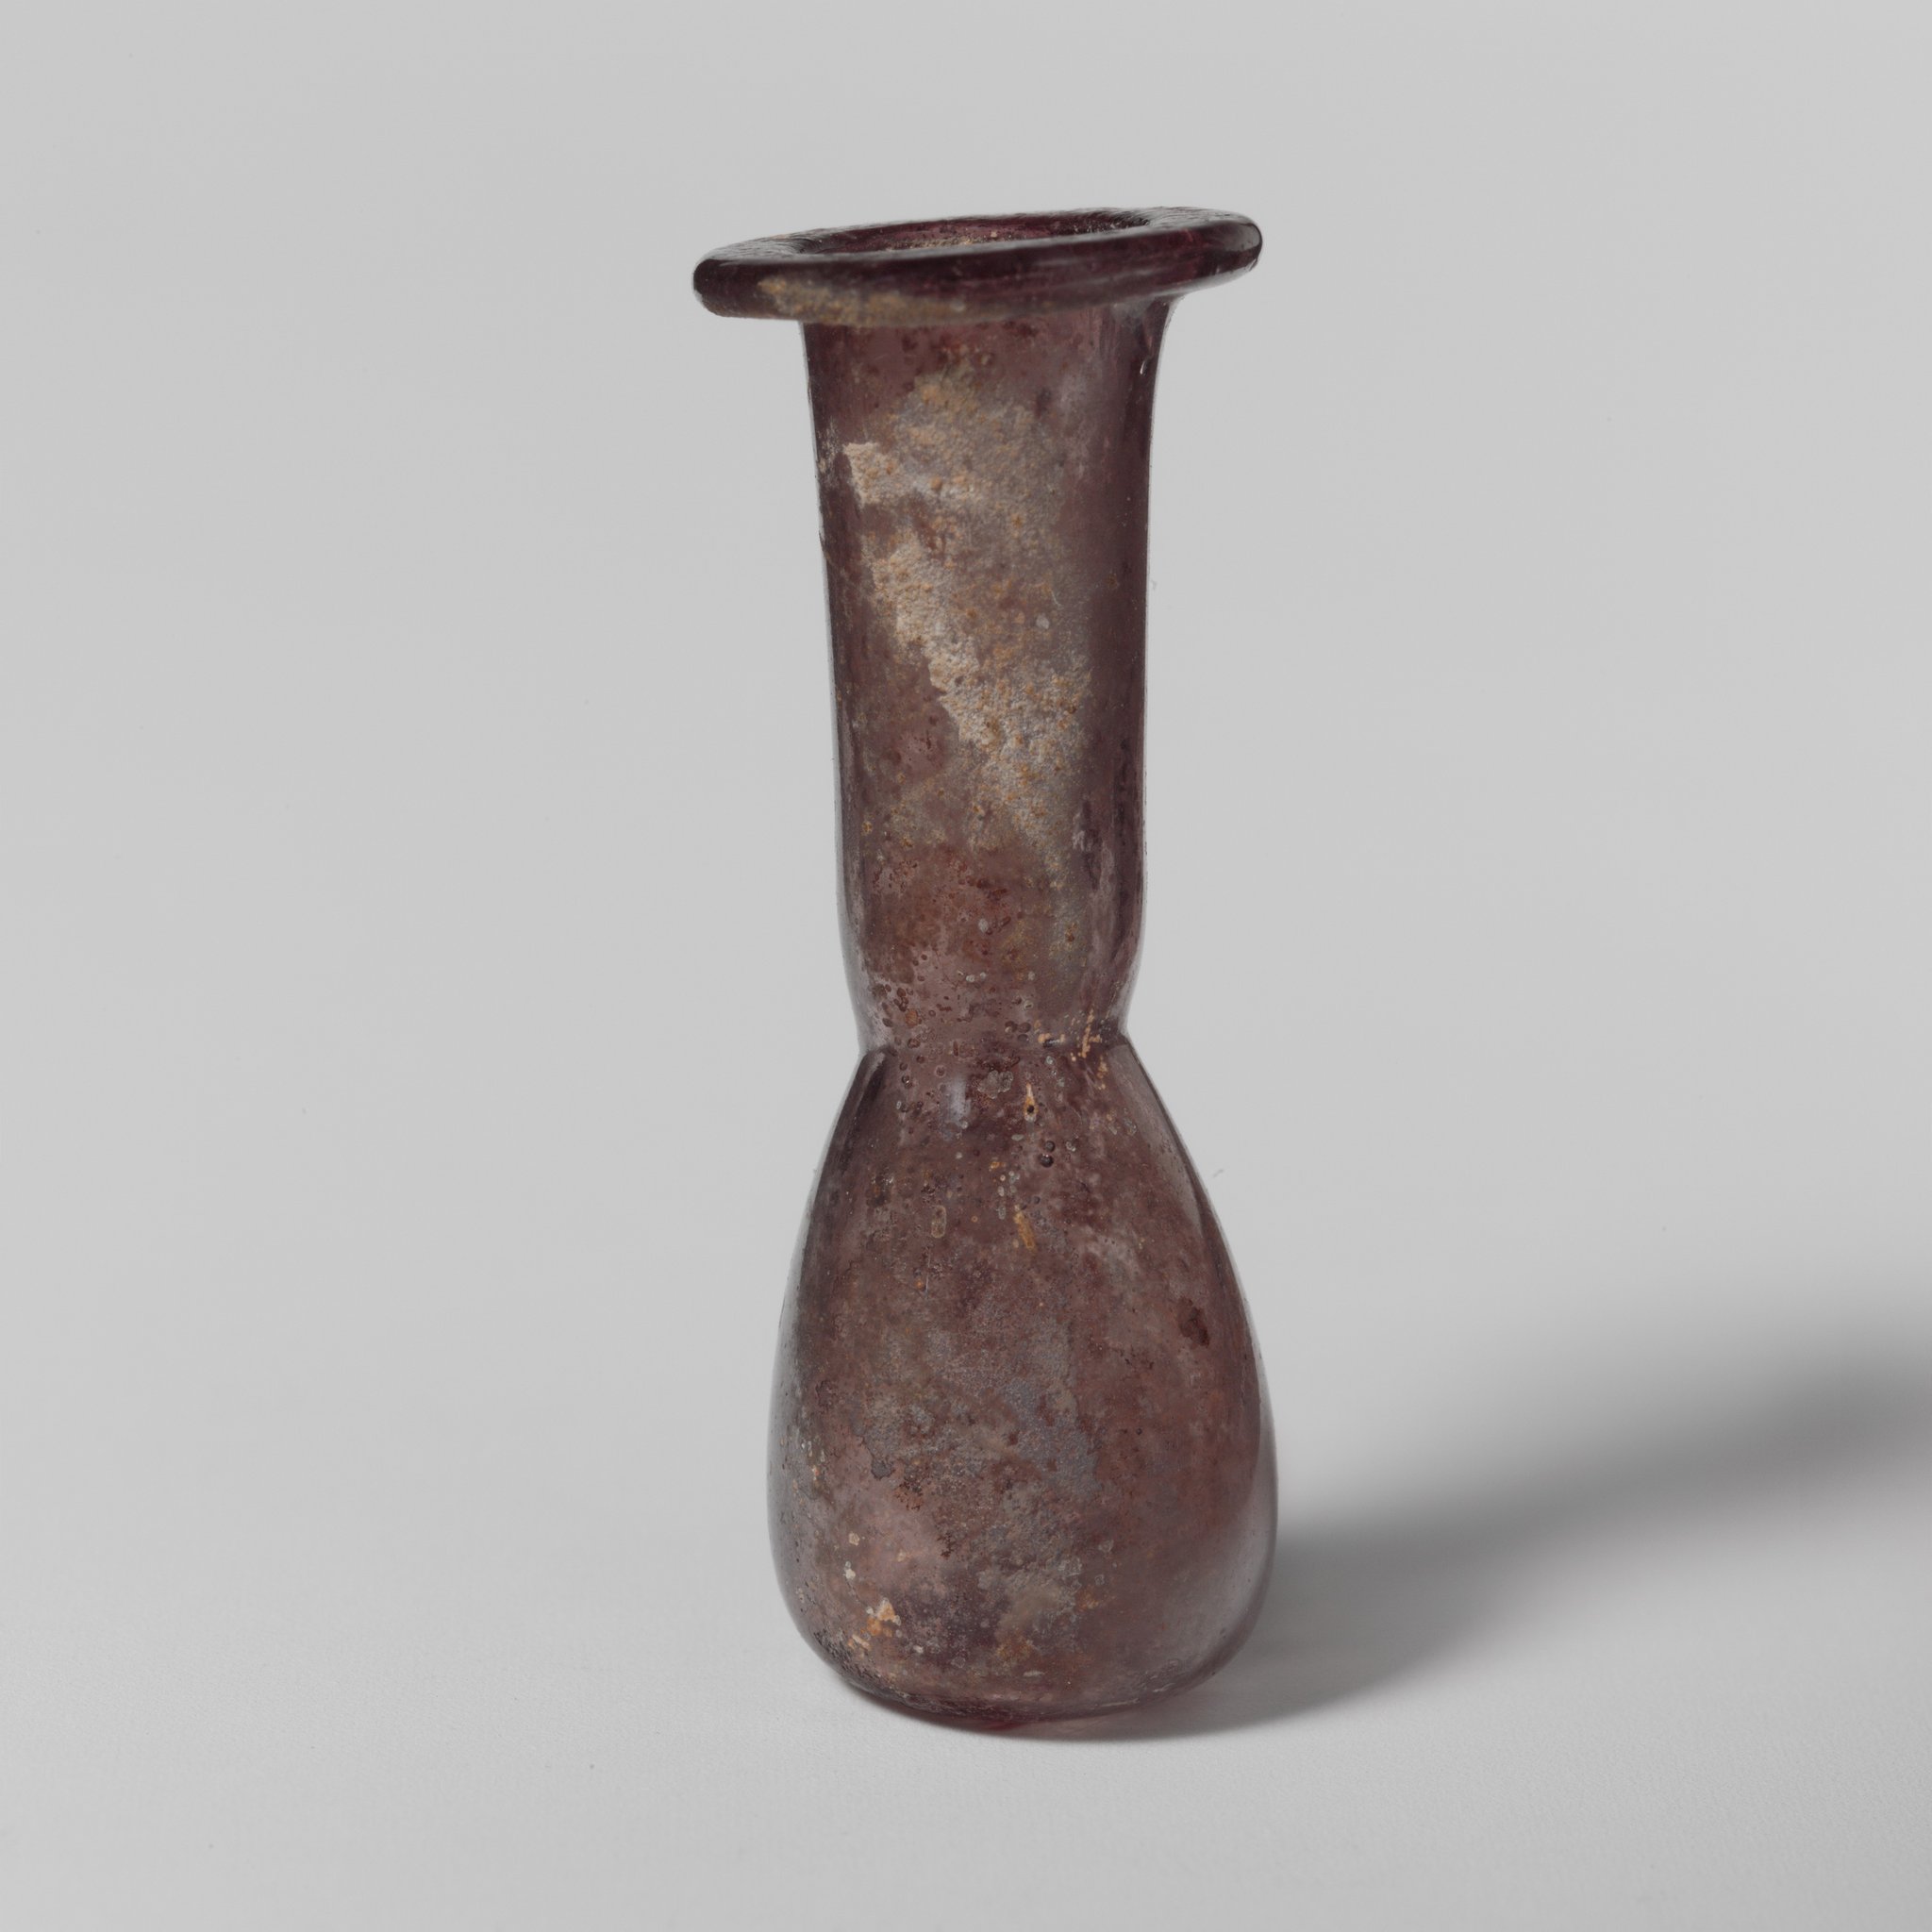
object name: perfume bottle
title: Glass perfume bottle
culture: roman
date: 1-100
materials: glass